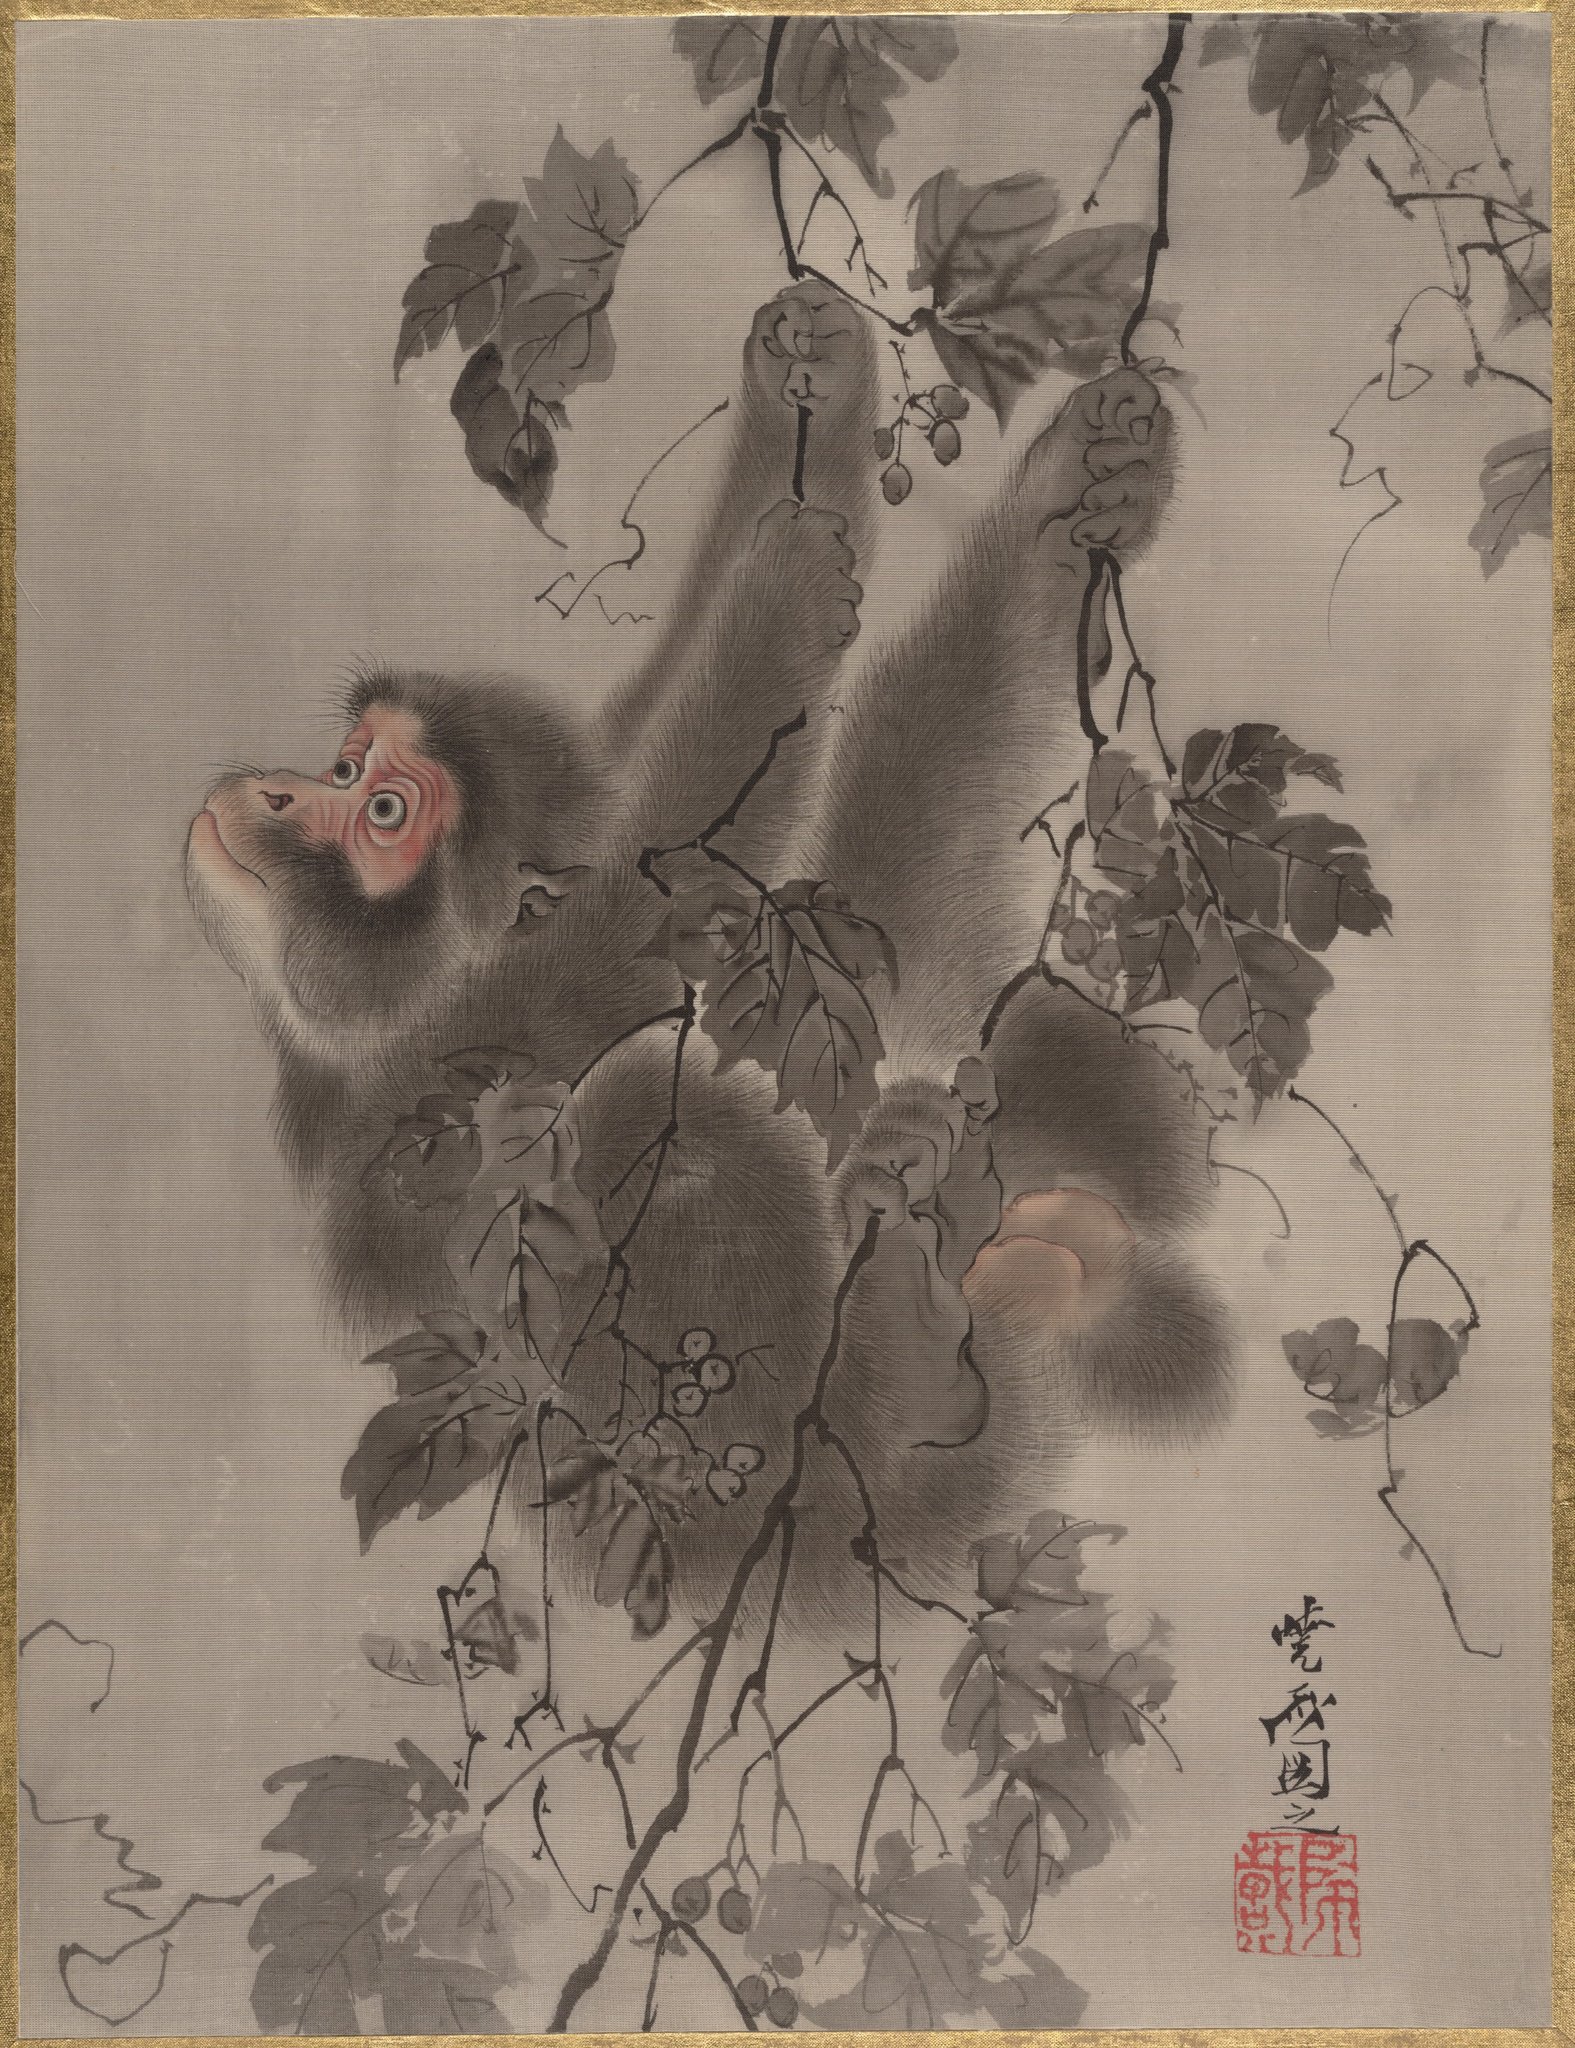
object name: album leaf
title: Monkey Hanging from Grapevines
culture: japanese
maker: kawanabe kyōsai 河鍋暁斎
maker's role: artist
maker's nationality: japanese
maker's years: 1831-1889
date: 1887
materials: ink, silk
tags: monkeys